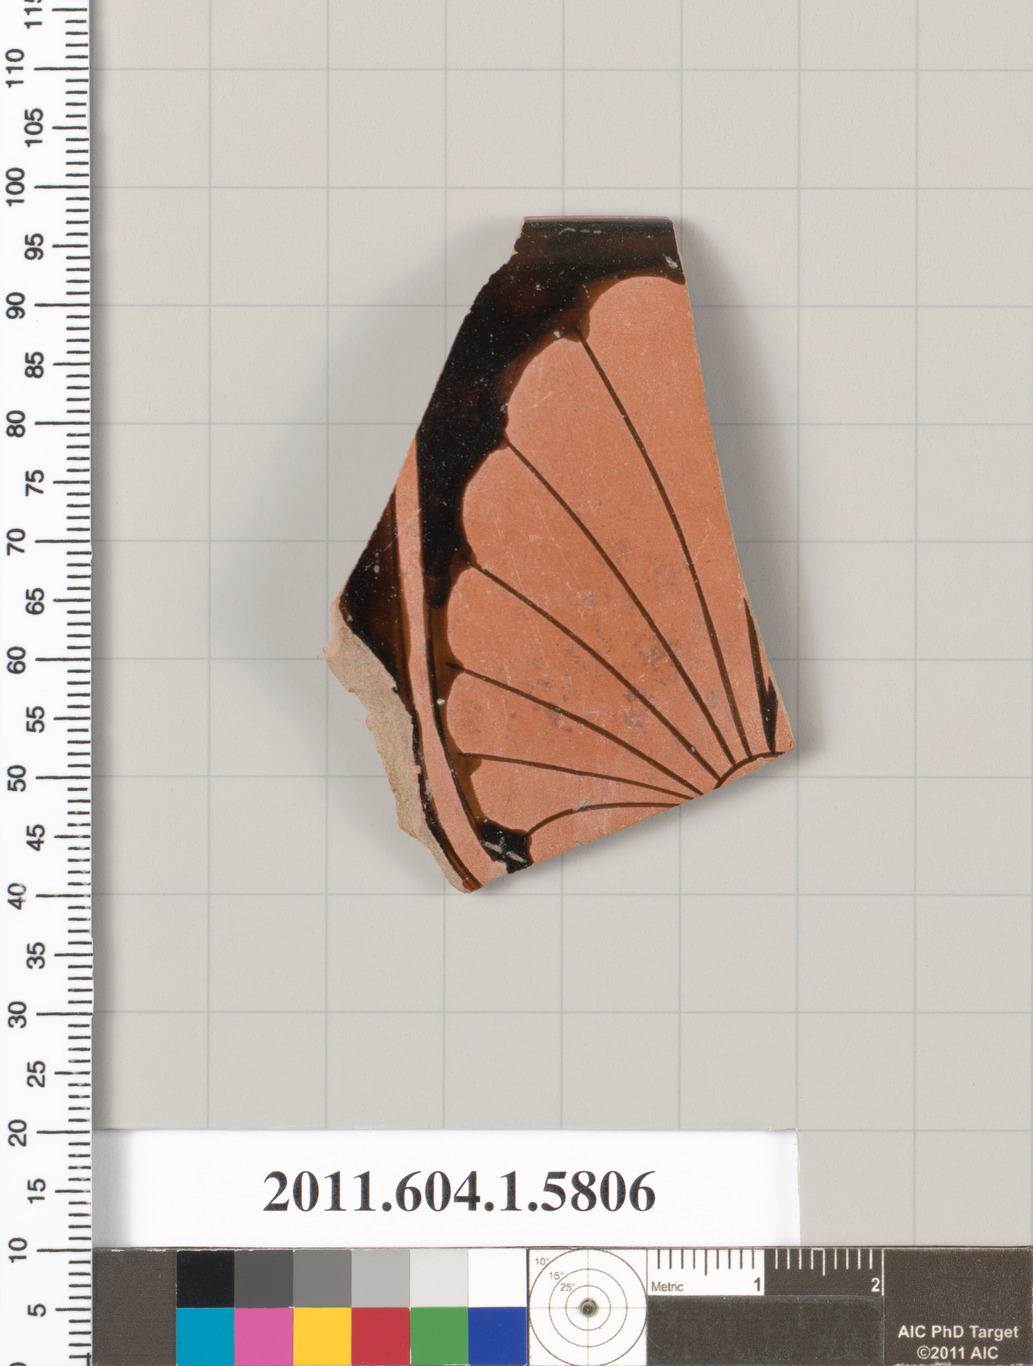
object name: kylix fragment, eye cup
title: Terracotta rim fragment of a kylix: eye-cup (drinking cup)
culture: greek, attic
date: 520-510 BCE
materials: terracotta